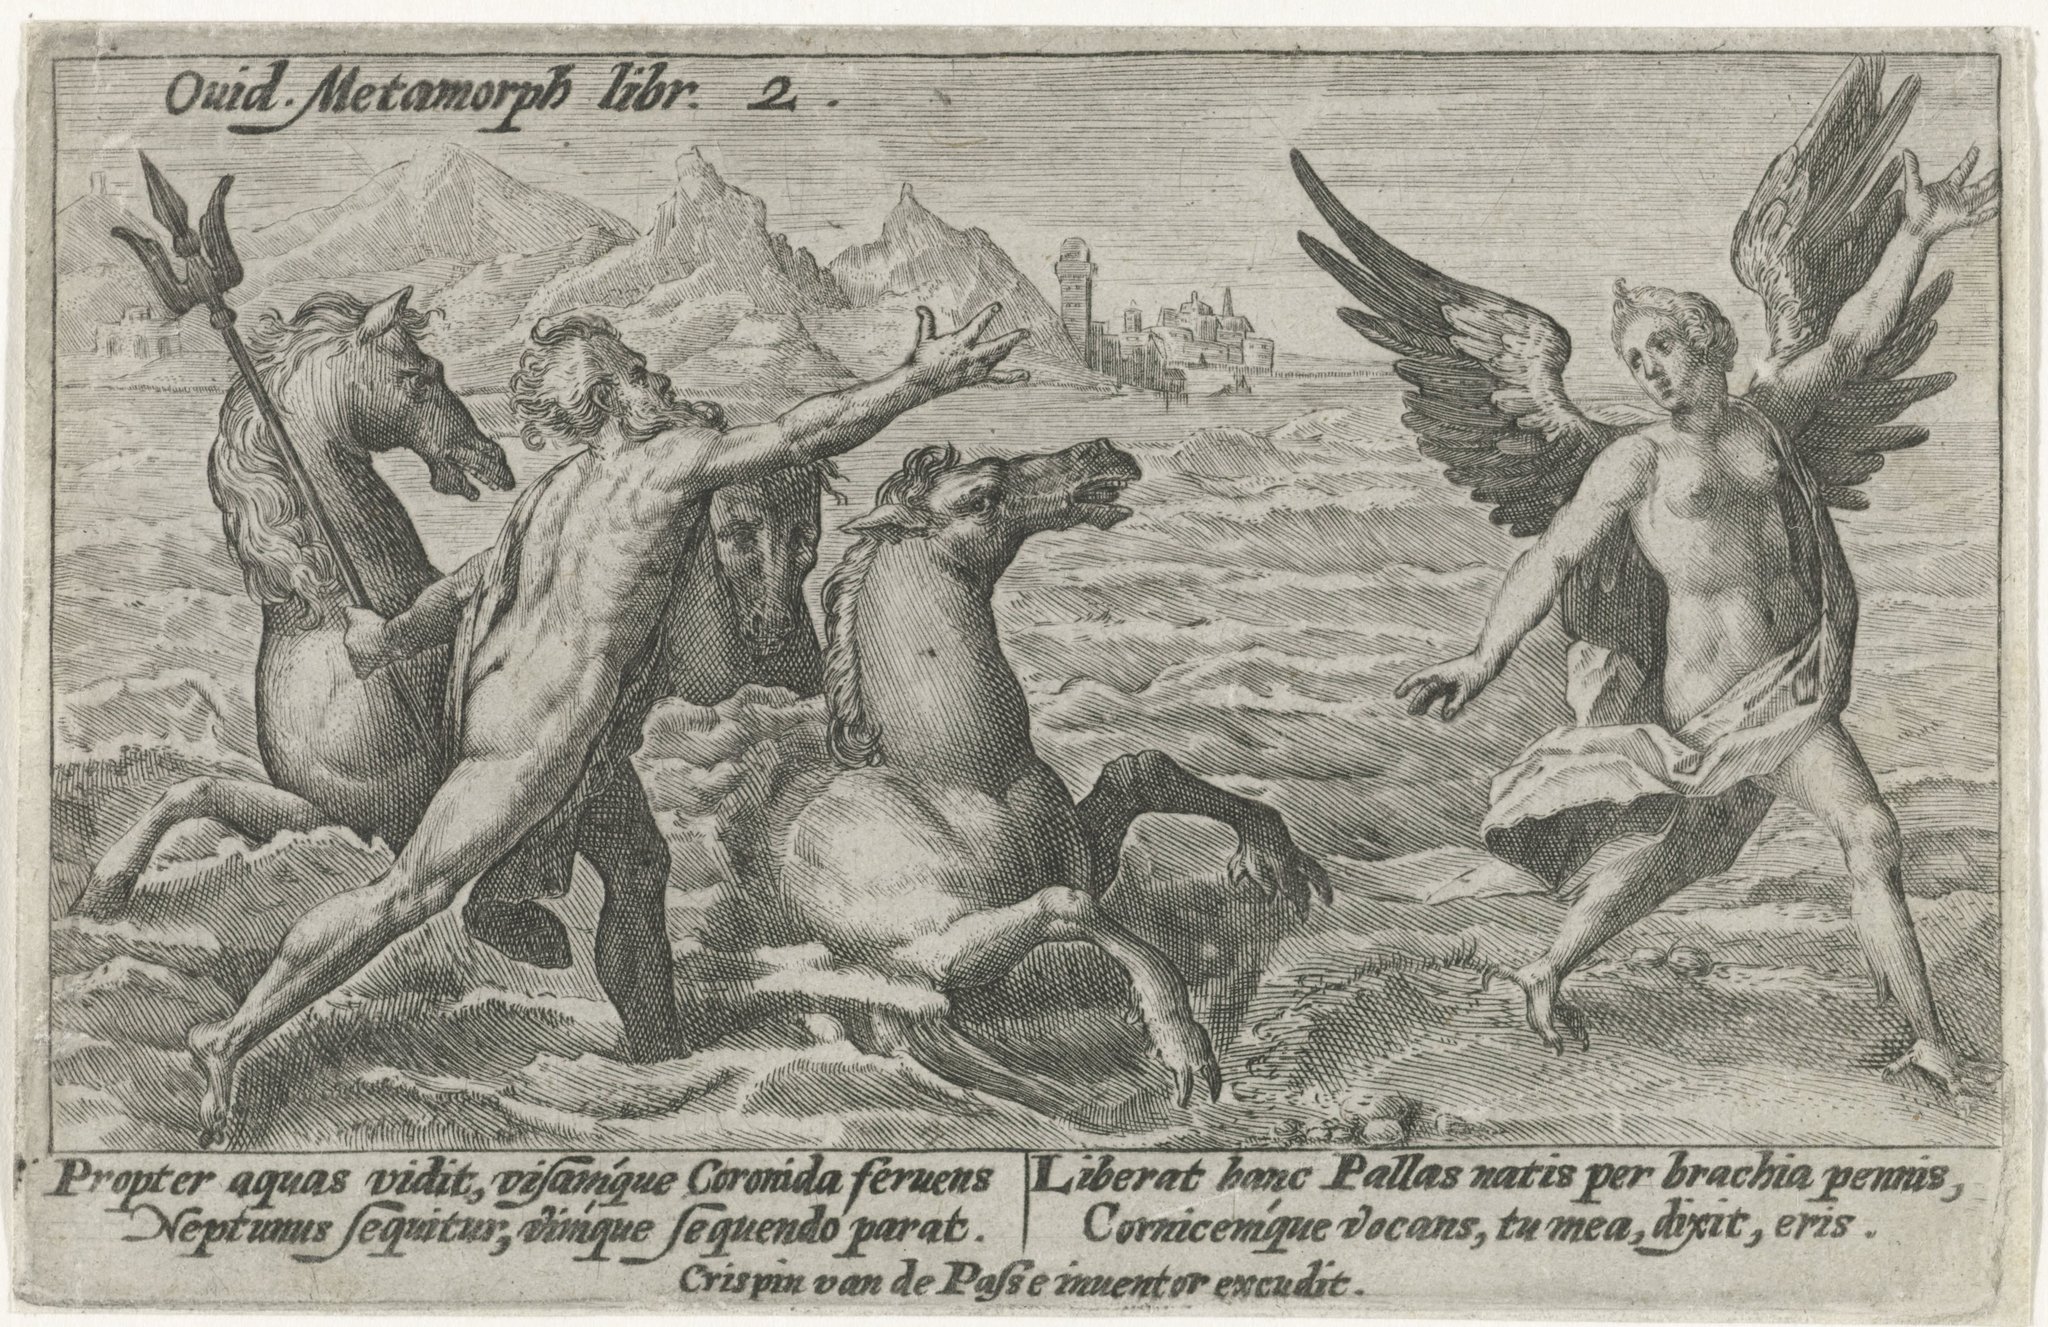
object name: print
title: Metamorfosen van Ovidius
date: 1602-1607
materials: paper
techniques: engraving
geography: cologne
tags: coronis changed into a crow: to escape the love of neptune, coronis, daughter of coroneus, is changed into a crow by minerva (ovid, metamorphoses ii 569)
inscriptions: collector's mark: Lugt 2228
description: Neptunus reikt naar Coronis, de dochter van Coroneus, die door hem werd begeerd. Om aan te ontkomen riep zij de hulp in van de goden, waarop Minerva haar in een kraai veranderde. In de marge een vierregelig onderschrift, in twee kolommen, in het Latijn.